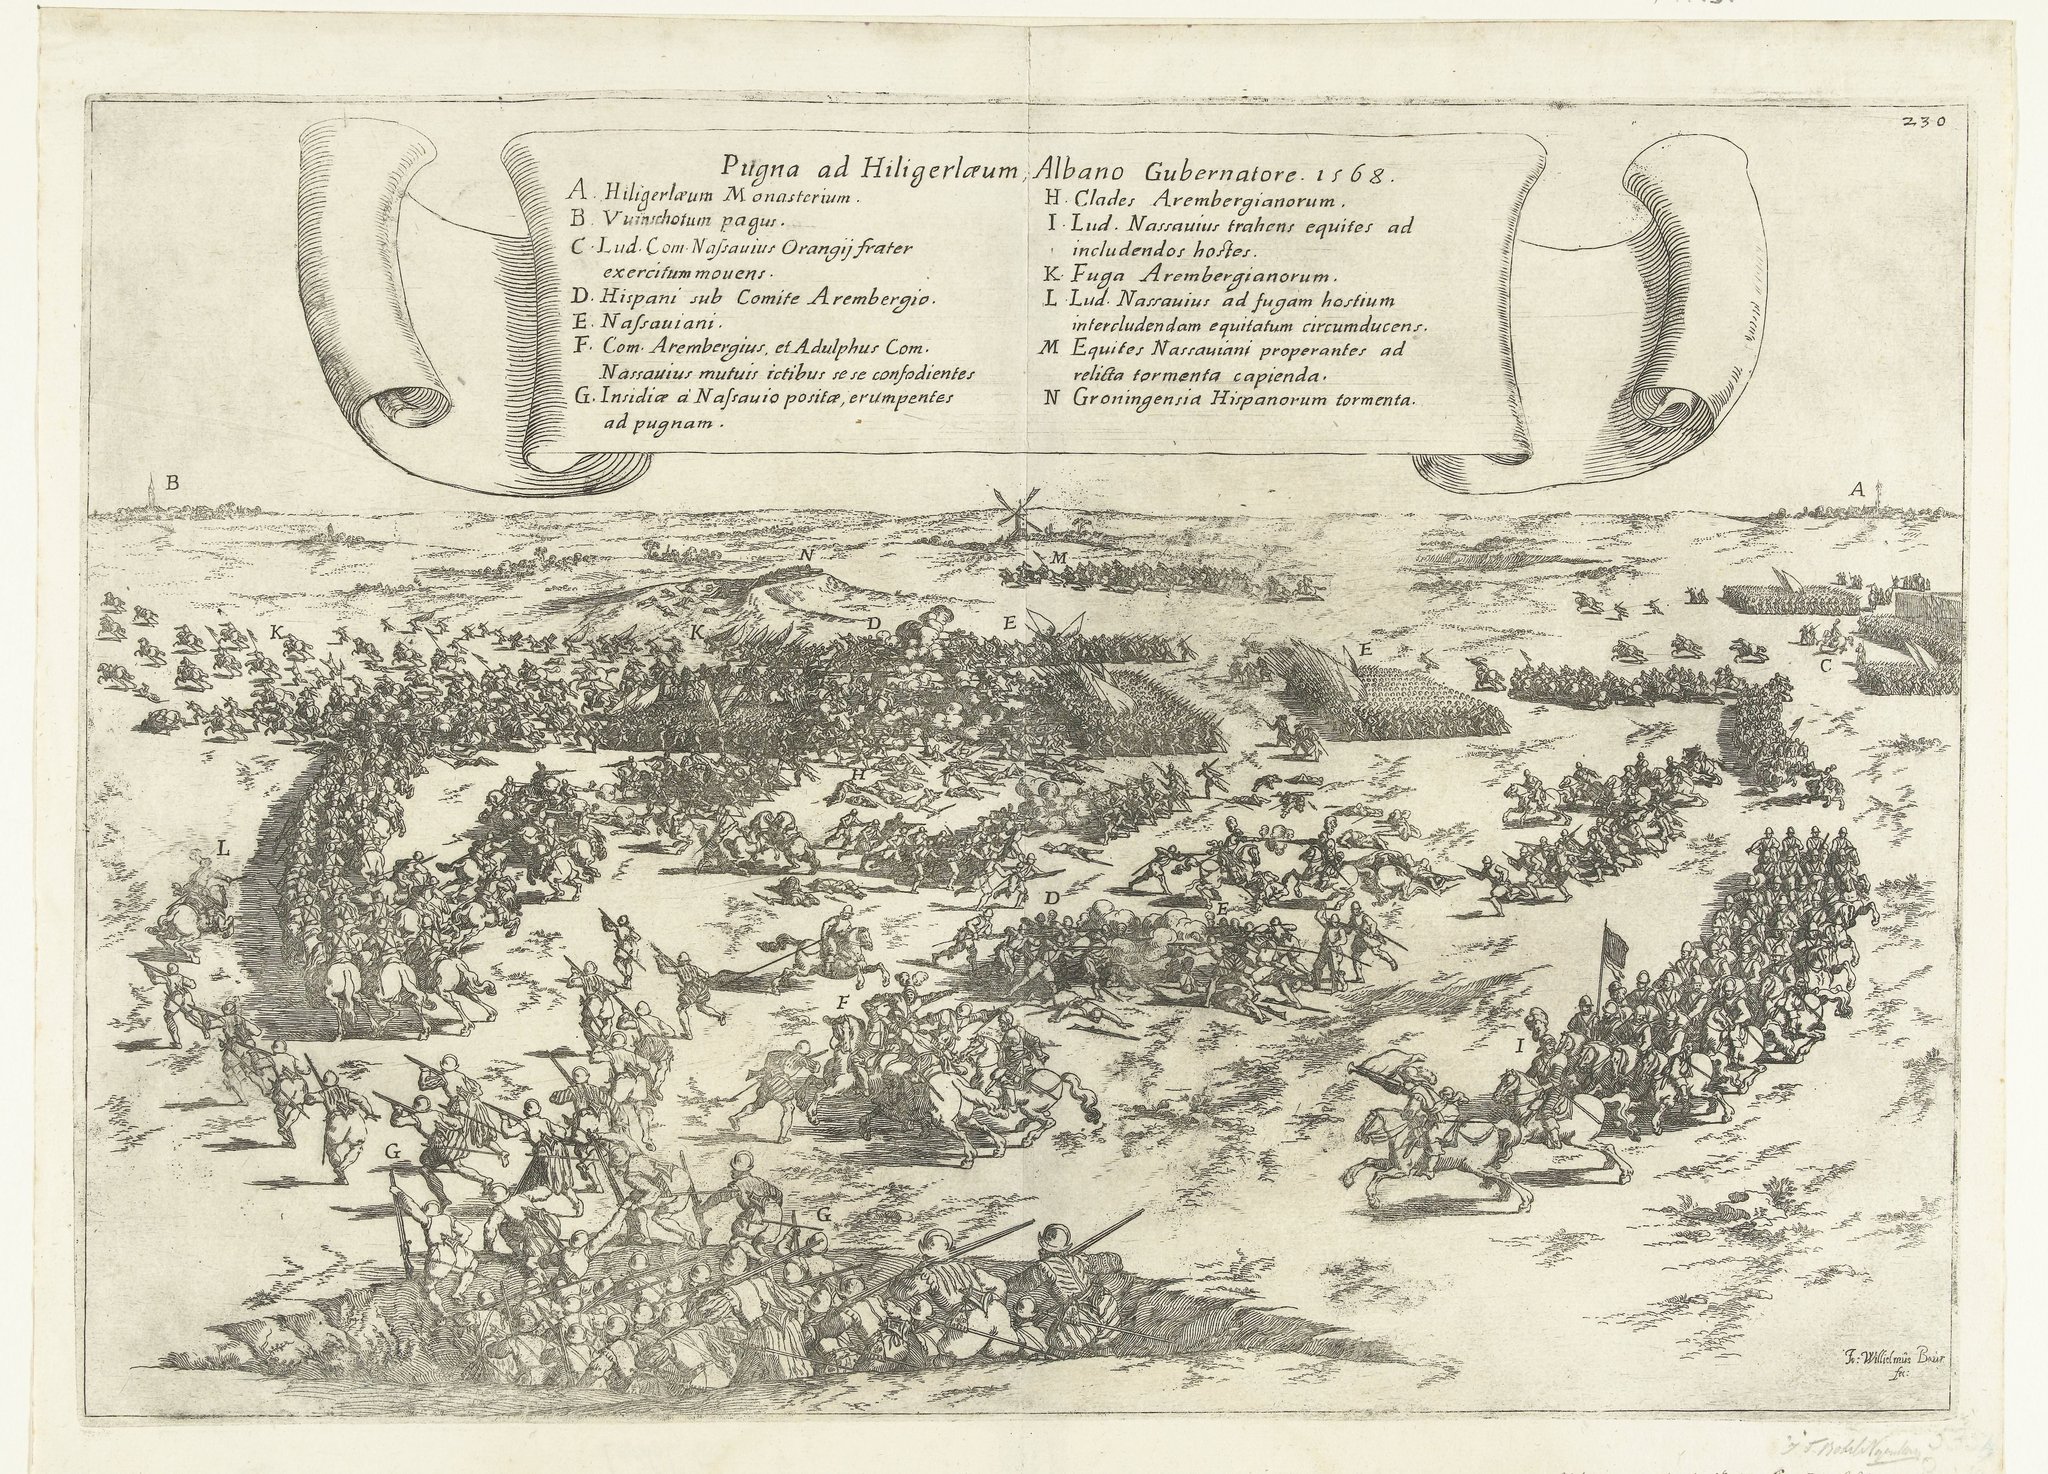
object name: history print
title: Pugna ad Hiligerlaeum, Albano Gubernatore. 1568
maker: johann wilhelm baur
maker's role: draughtsman, painter, print maker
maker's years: 1607-1642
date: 1630-1632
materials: paper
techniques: etching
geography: rome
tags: jean de ligne (duke of arenberg), battle (+ land forces)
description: Slag bij Heiligerlee, 23 mei 1568. Gezicht op het slagveld, in het midden het sneuvelen van graaf Adolf en de graaf van Arenberg. Bovenin een banderol met de titel en legenda A-N in het Latijn.